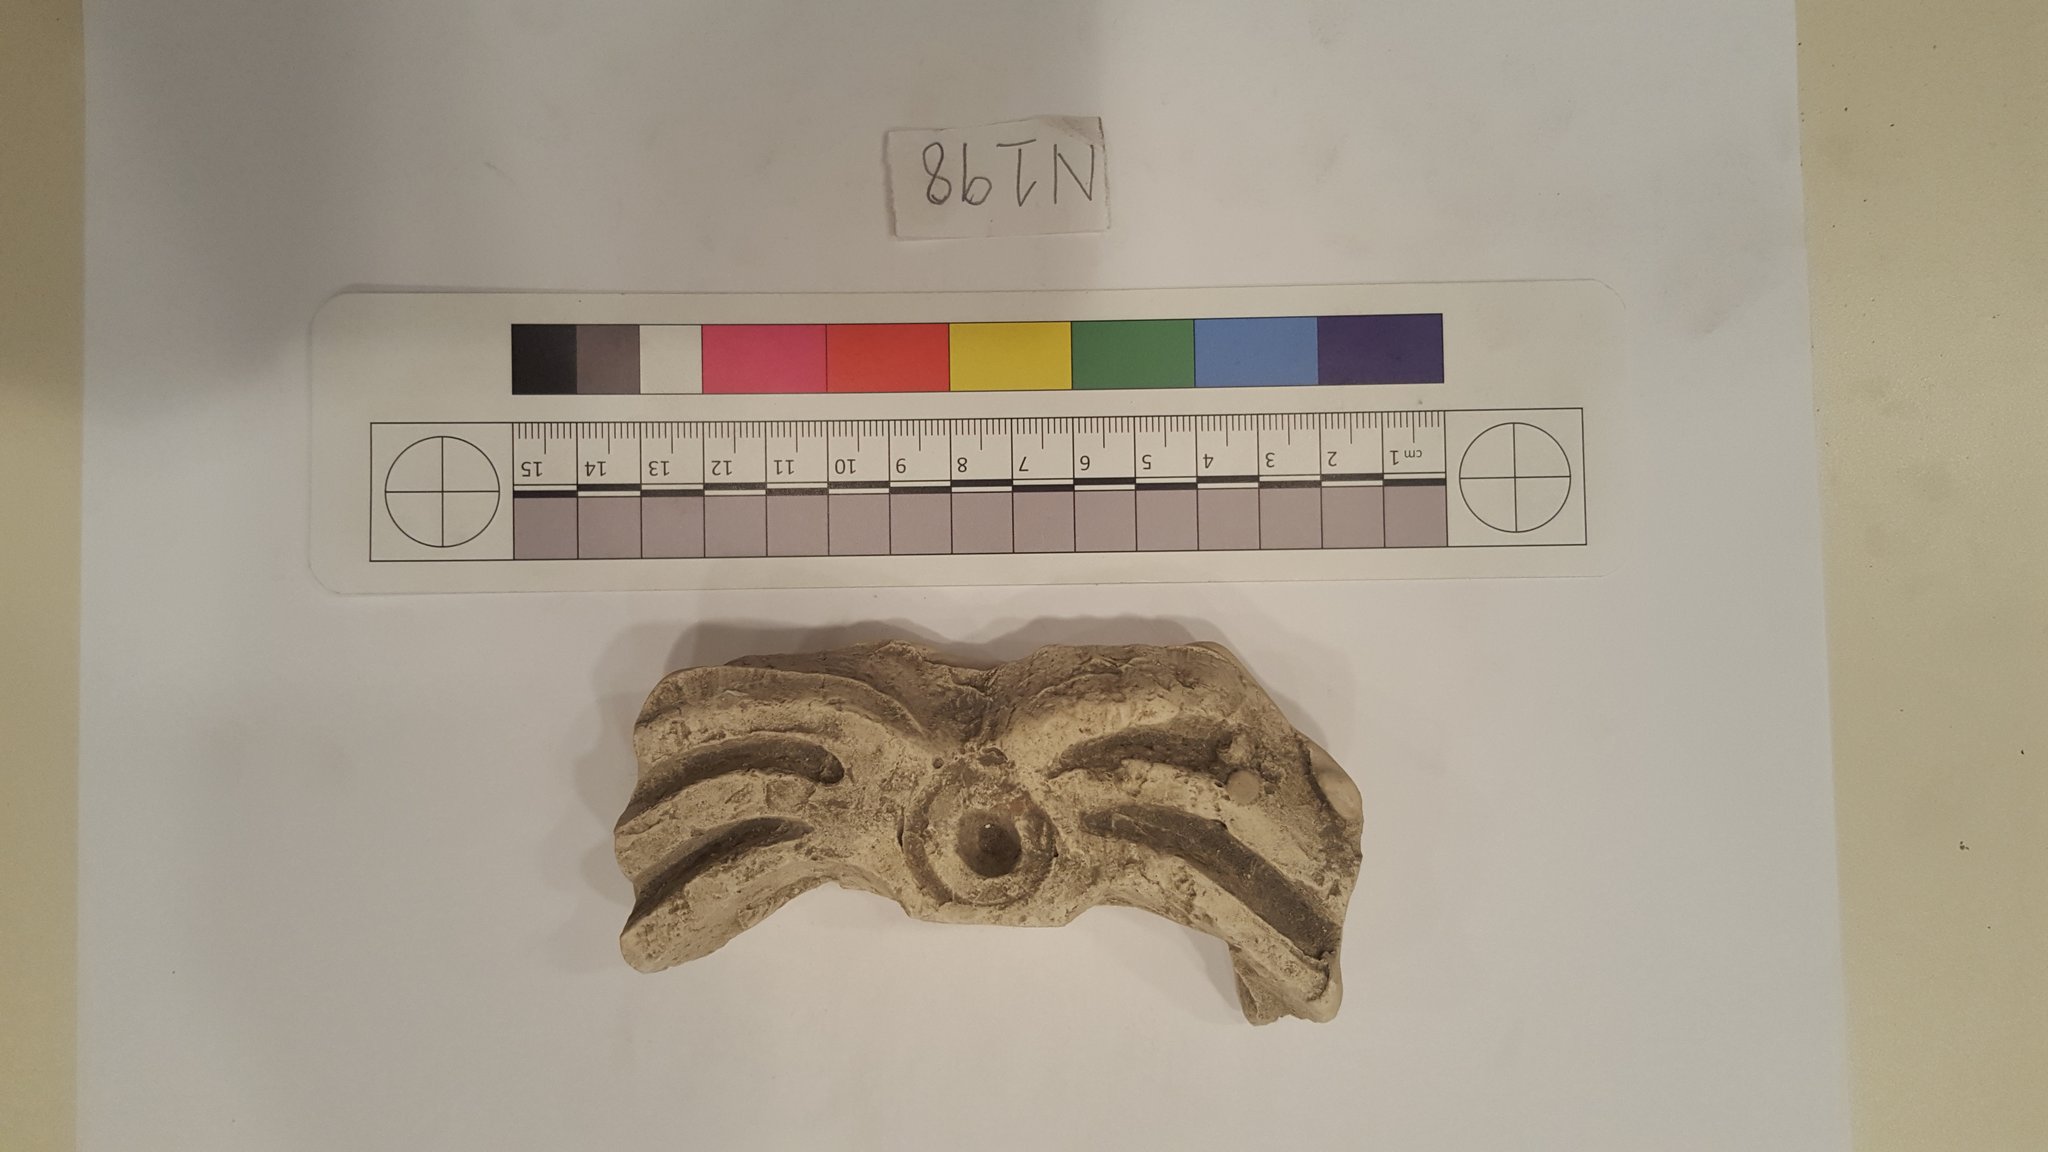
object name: fragment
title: Stucco Fragment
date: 701-1200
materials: plaster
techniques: carving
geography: iran